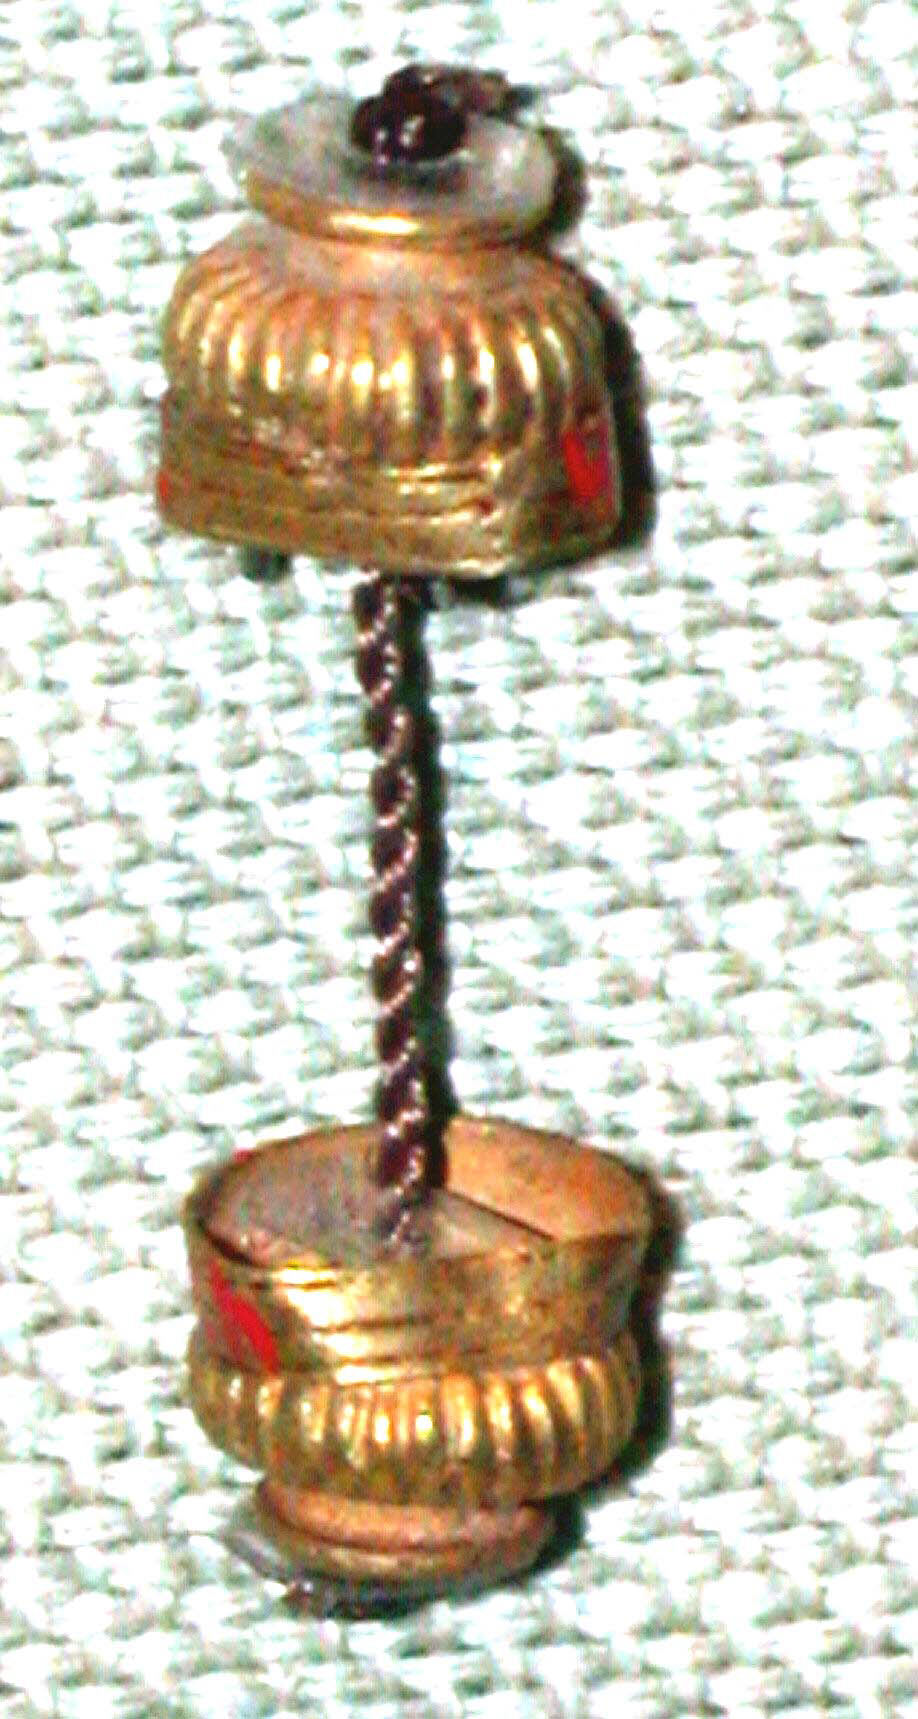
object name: bead and pendant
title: Necklace pendants and beads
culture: babylonian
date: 1800-1601 BCE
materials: gold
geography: mesopotamia